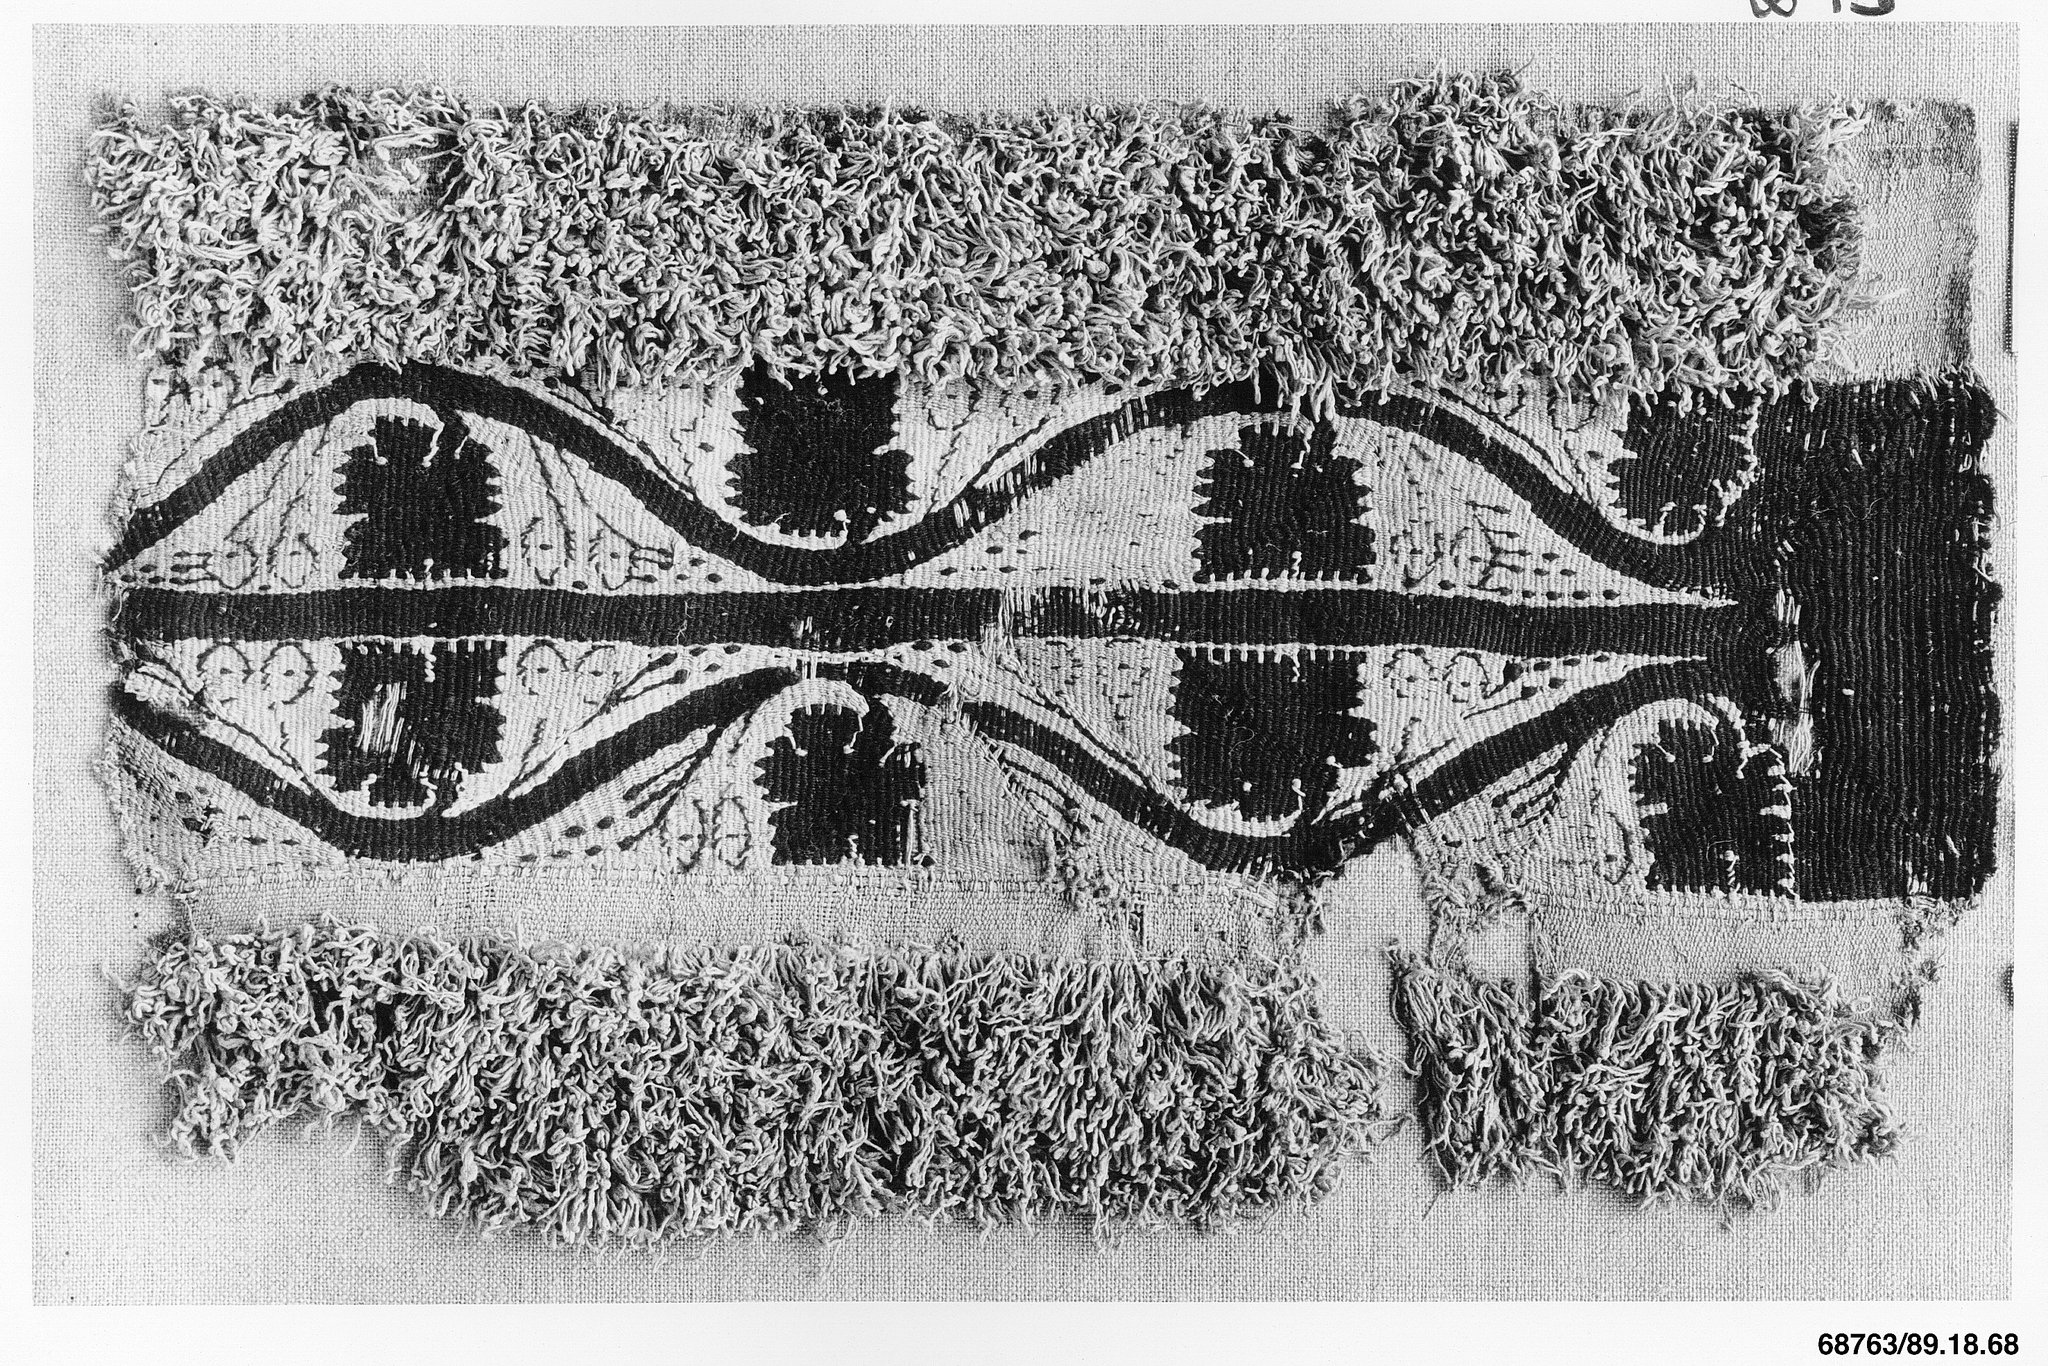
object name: textile fragment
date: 201-400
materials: linen, wool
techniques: weave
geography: egypt